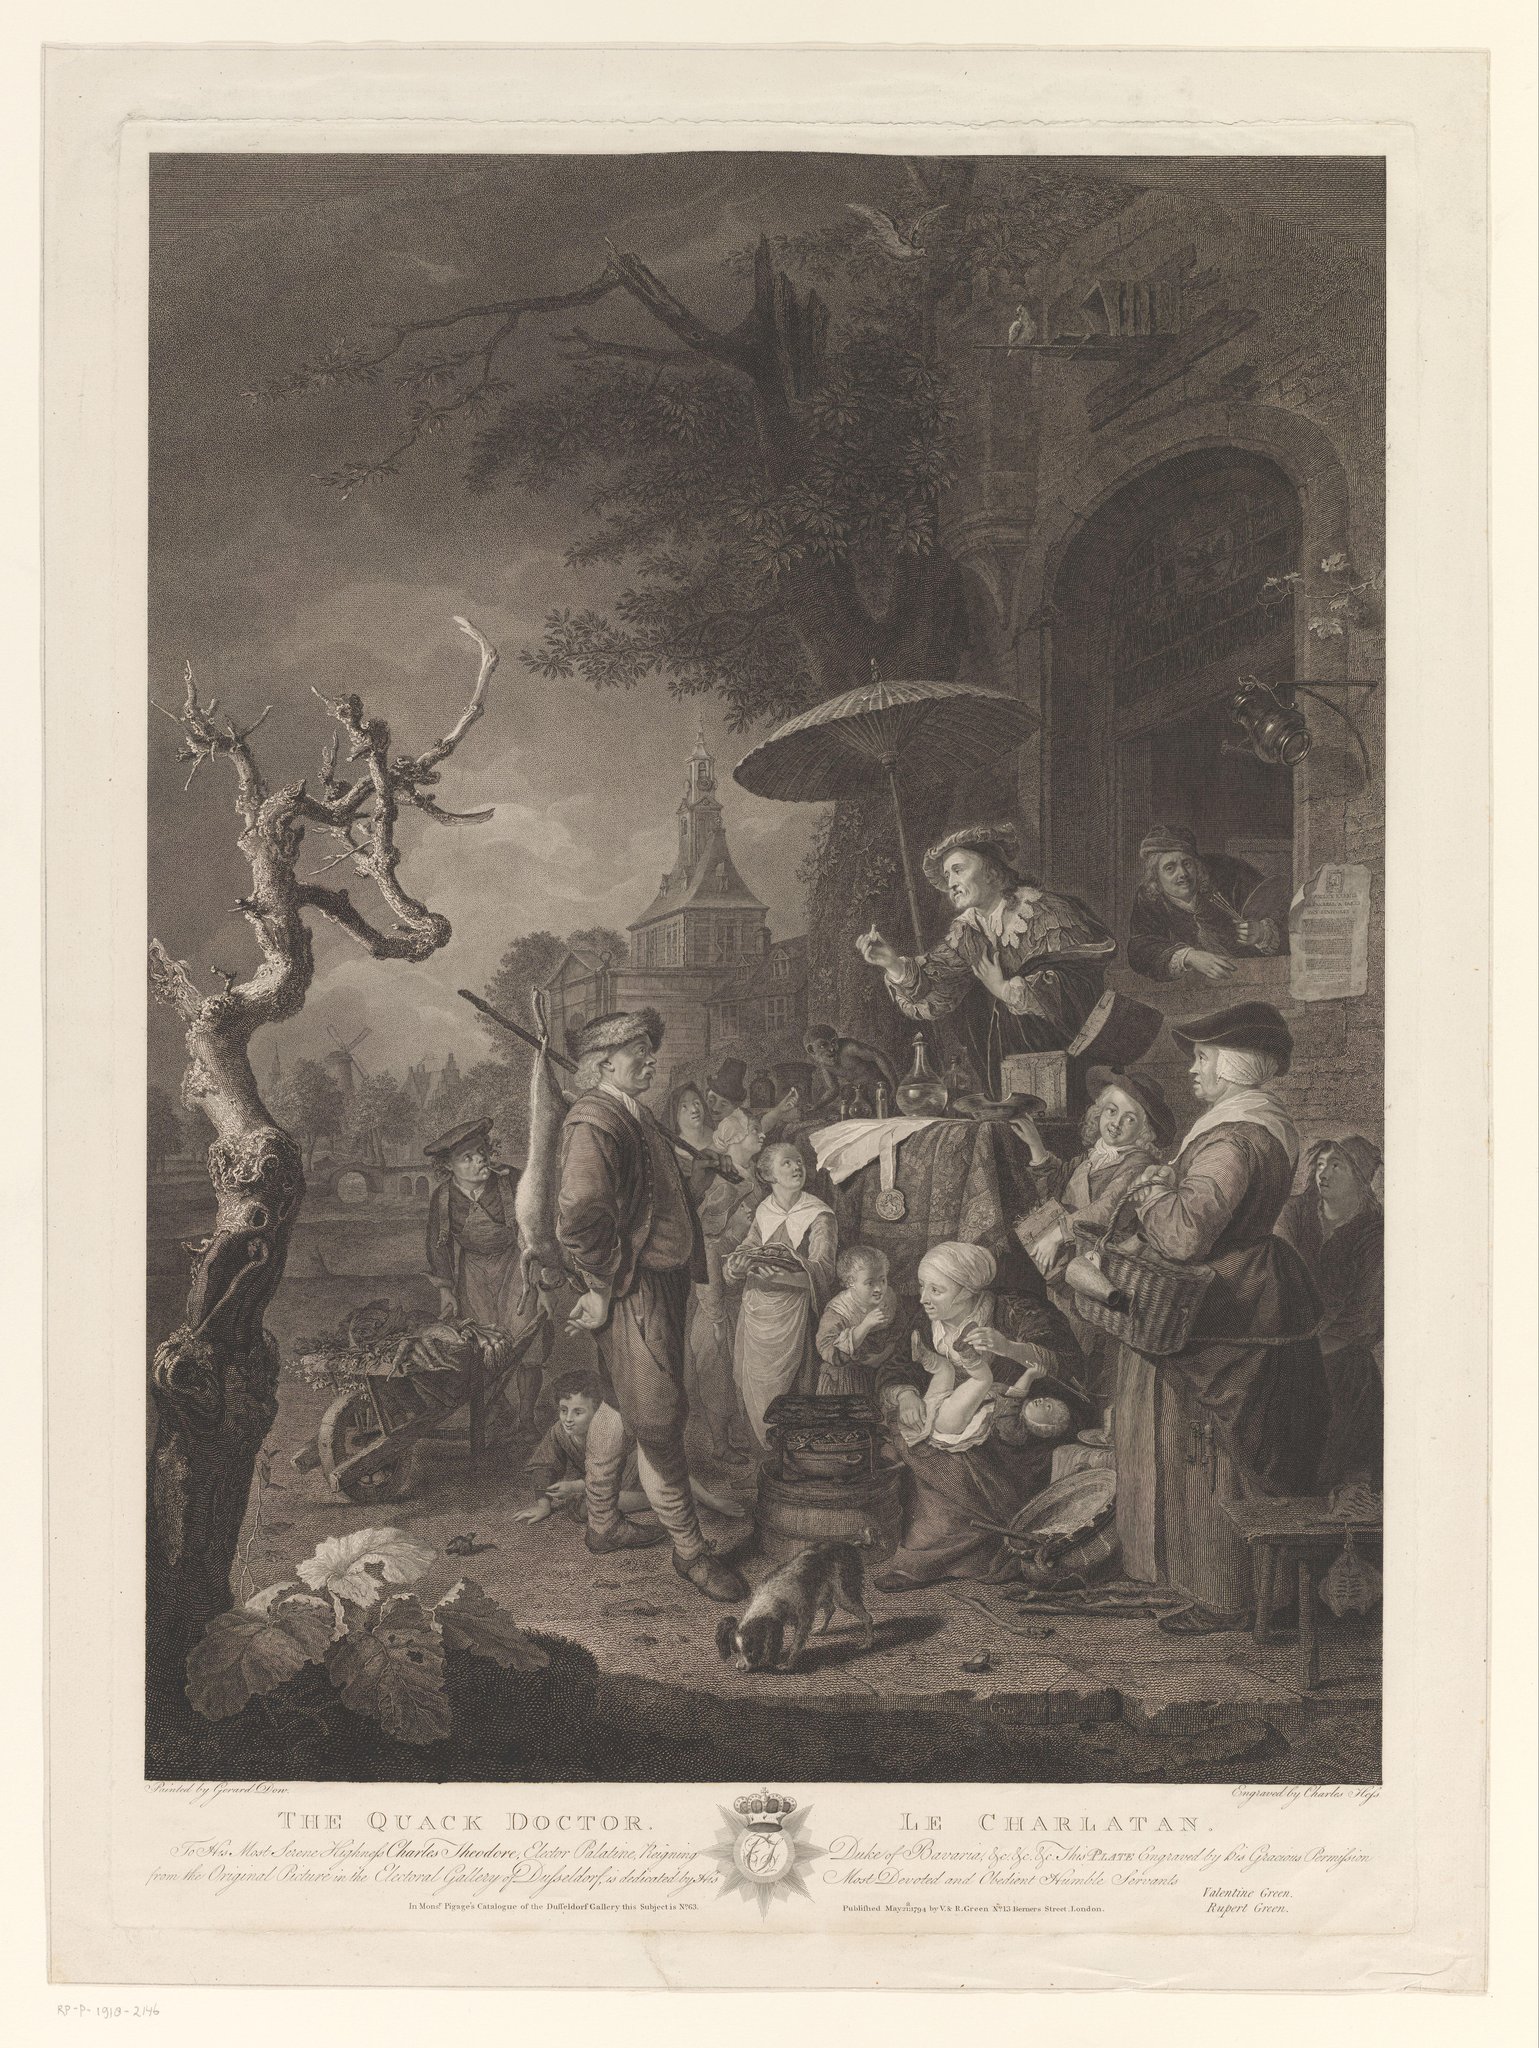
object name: print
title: De Kwakzalver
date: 1794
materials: paper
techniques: etching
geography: london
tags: monkeys, apes, quack, charlatan, mountebank, 'saltimbanco', stall, booth (~ market), portrait, self-portrait of painter, washing and changing baby, leiden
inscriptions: collector's mark: Lugt 2228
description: Het schilderij waarop deze prent is gebaseerd is gemaakt door Gerard Dou in 1652 en bevindt zich in de collectie van het Boijmans Van Beuningen in Rotterdam.